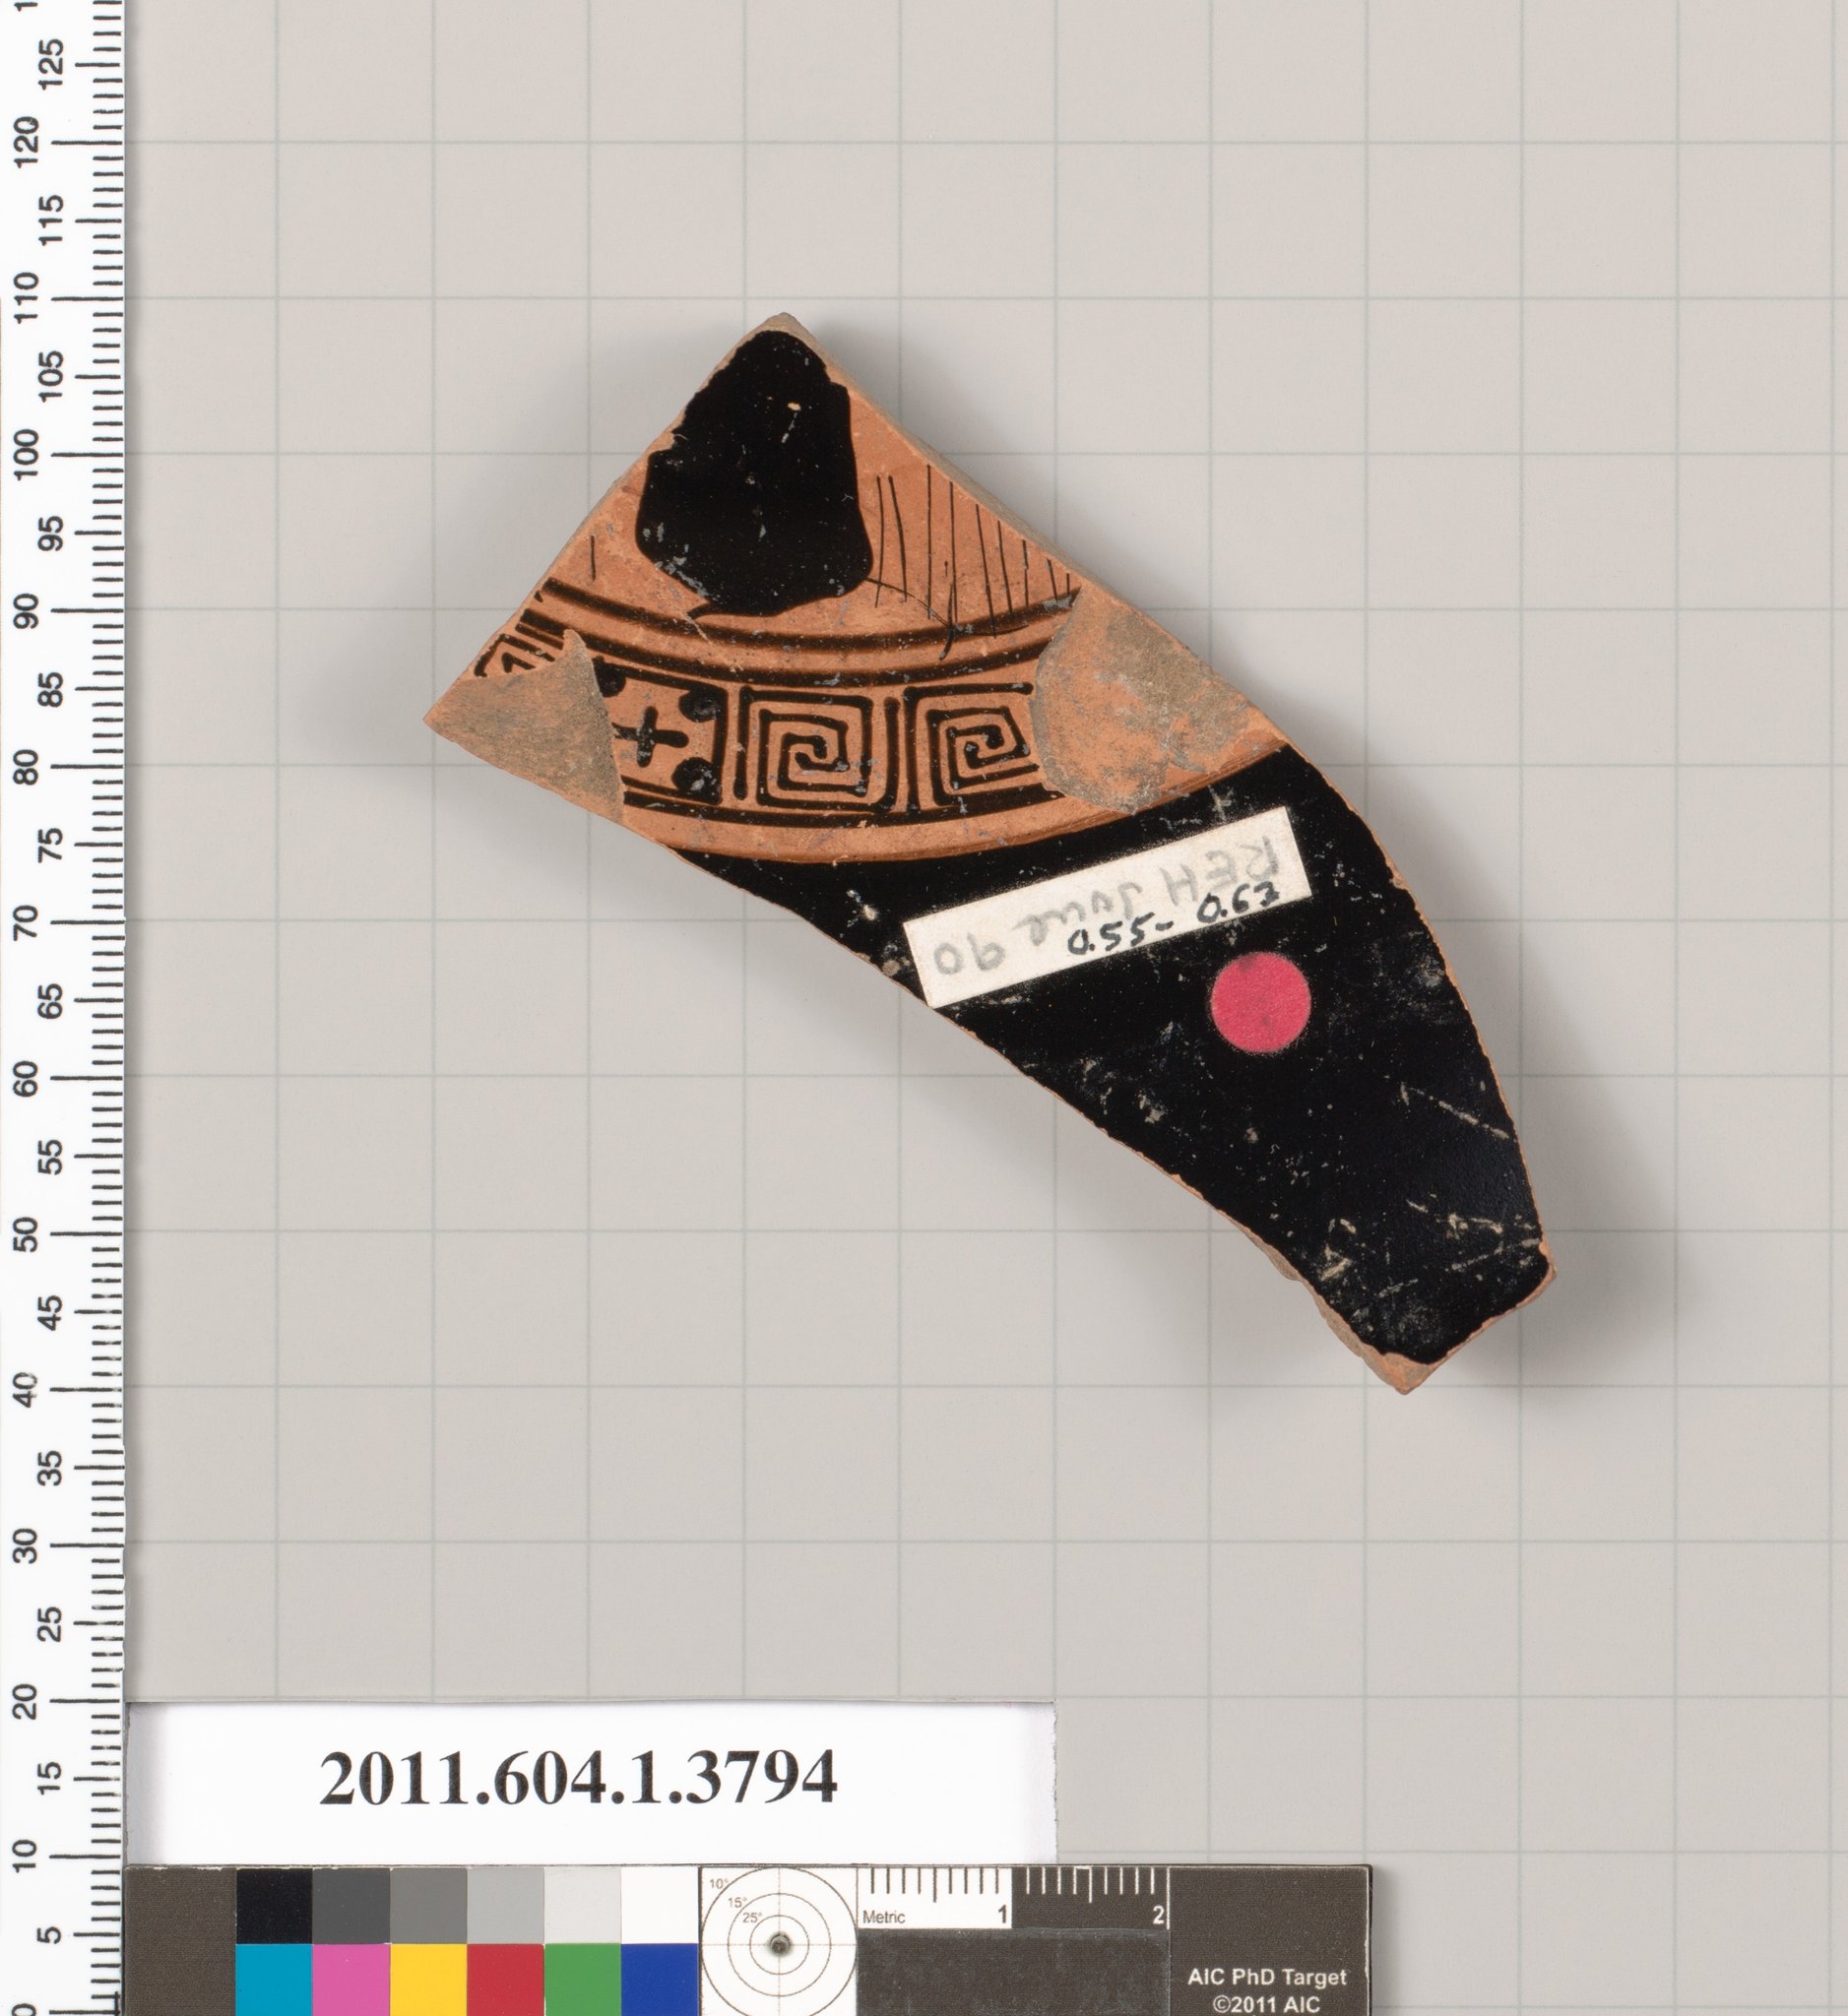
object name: kylix fragment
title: Terracotta fragment of a kylix (drinking cup)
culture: greek, attic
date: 475-451 BCE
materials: terracotta